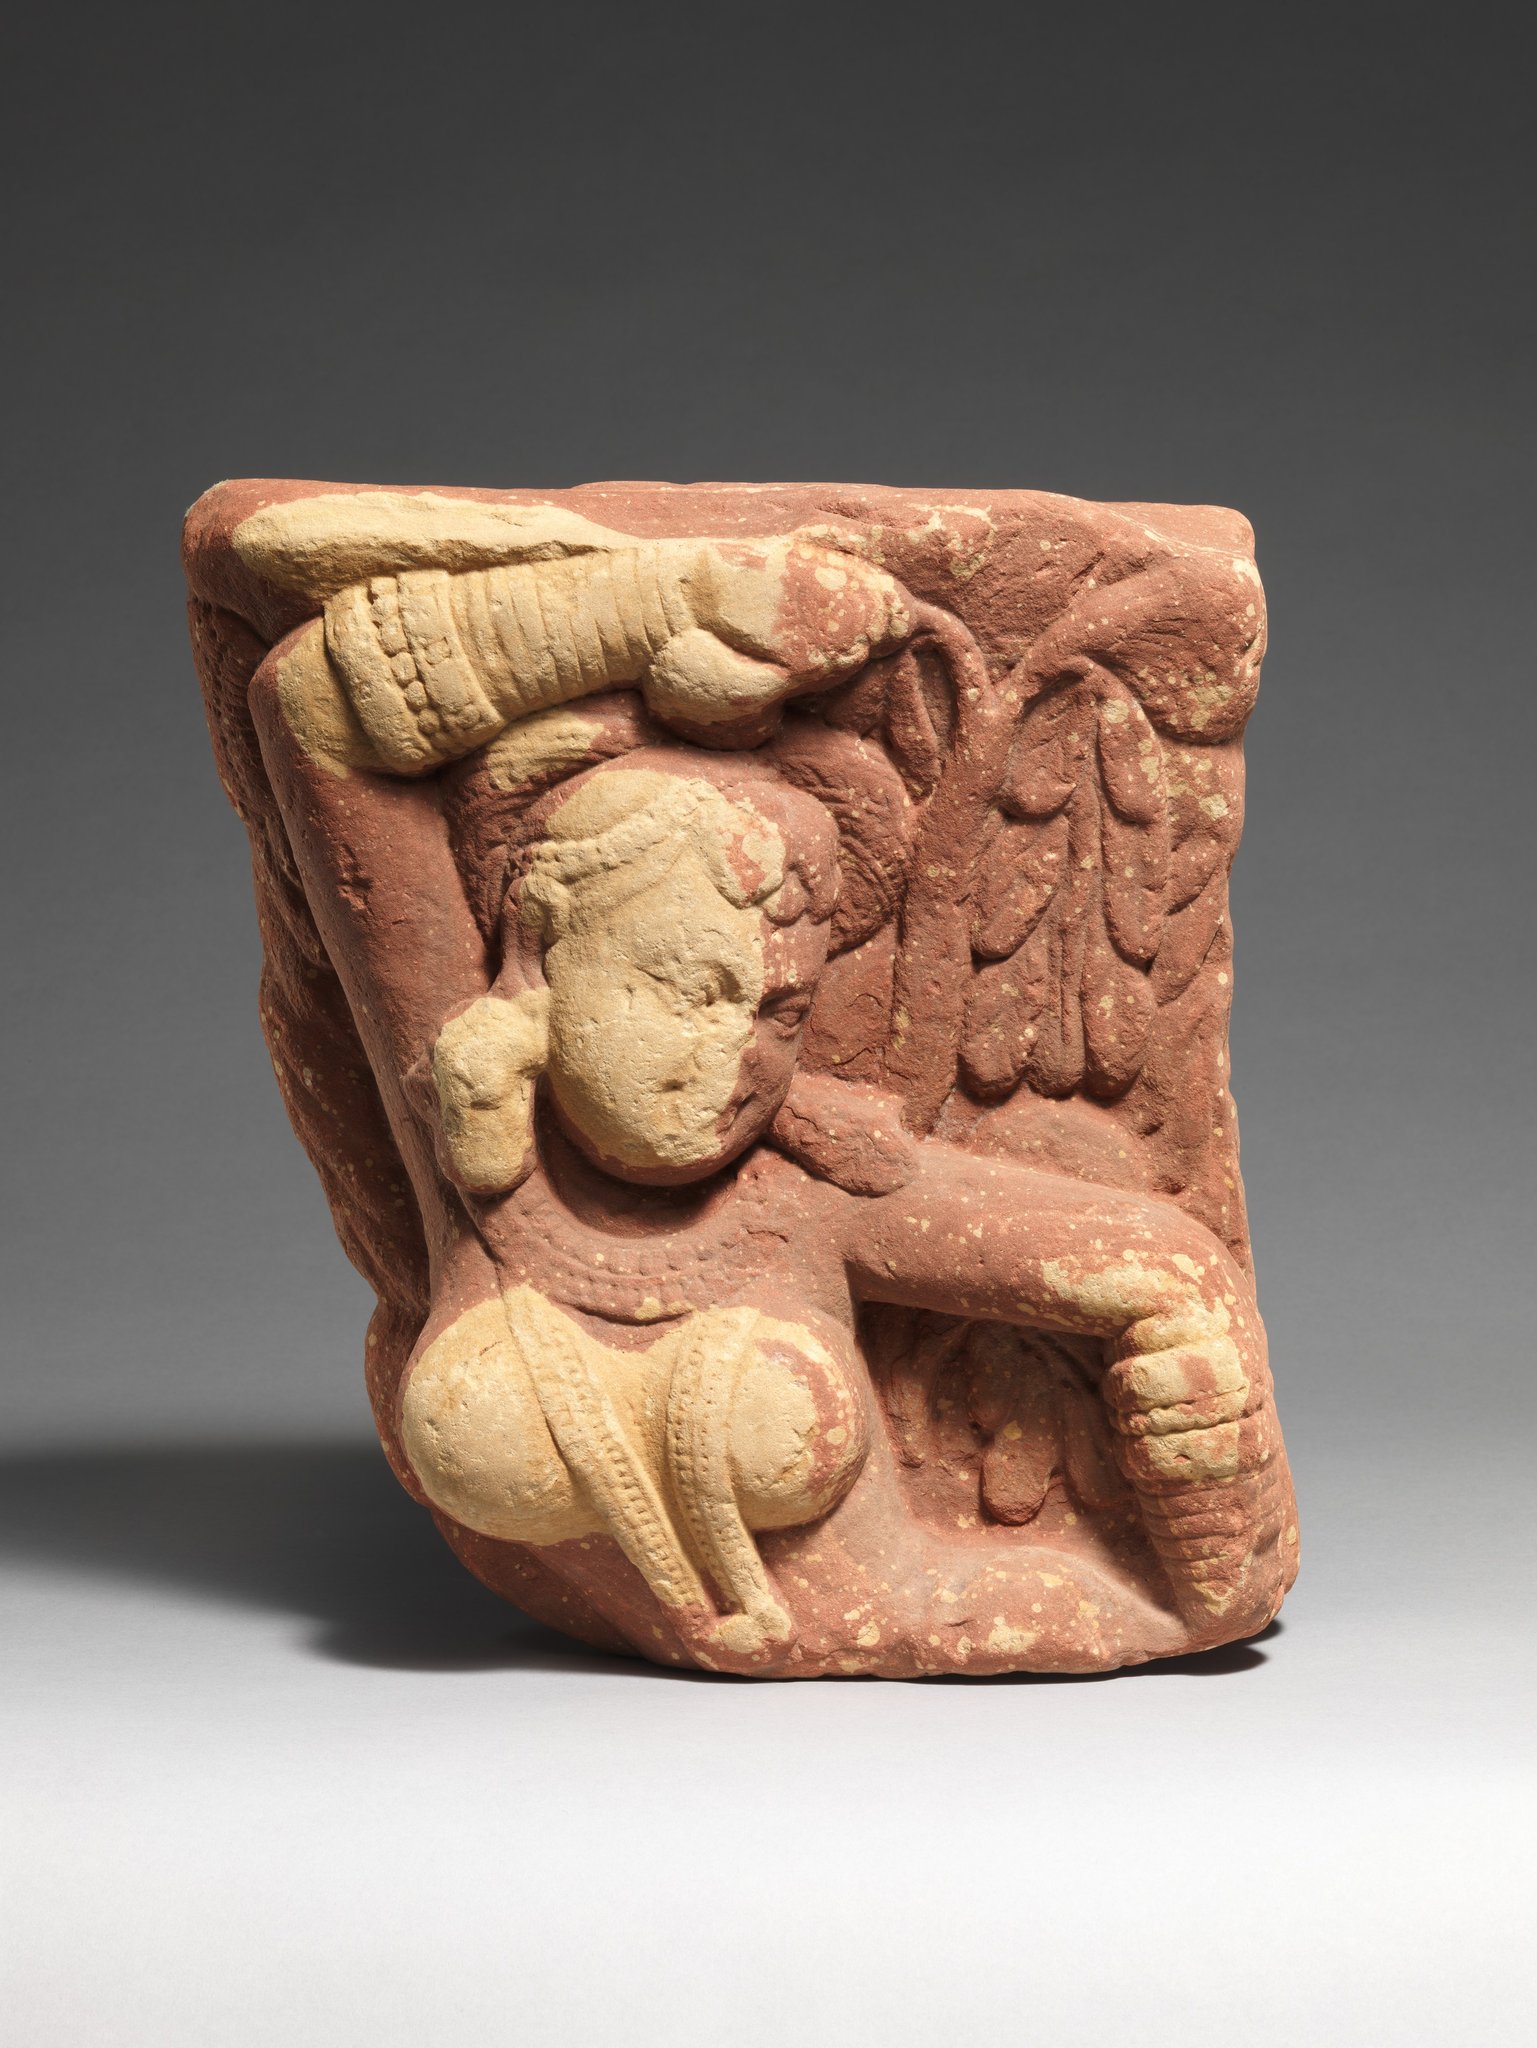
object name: bracket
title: Tree Spirit Deity (Yakshi)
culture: indian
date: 1-200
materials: stone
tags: kushan,mathura,deities